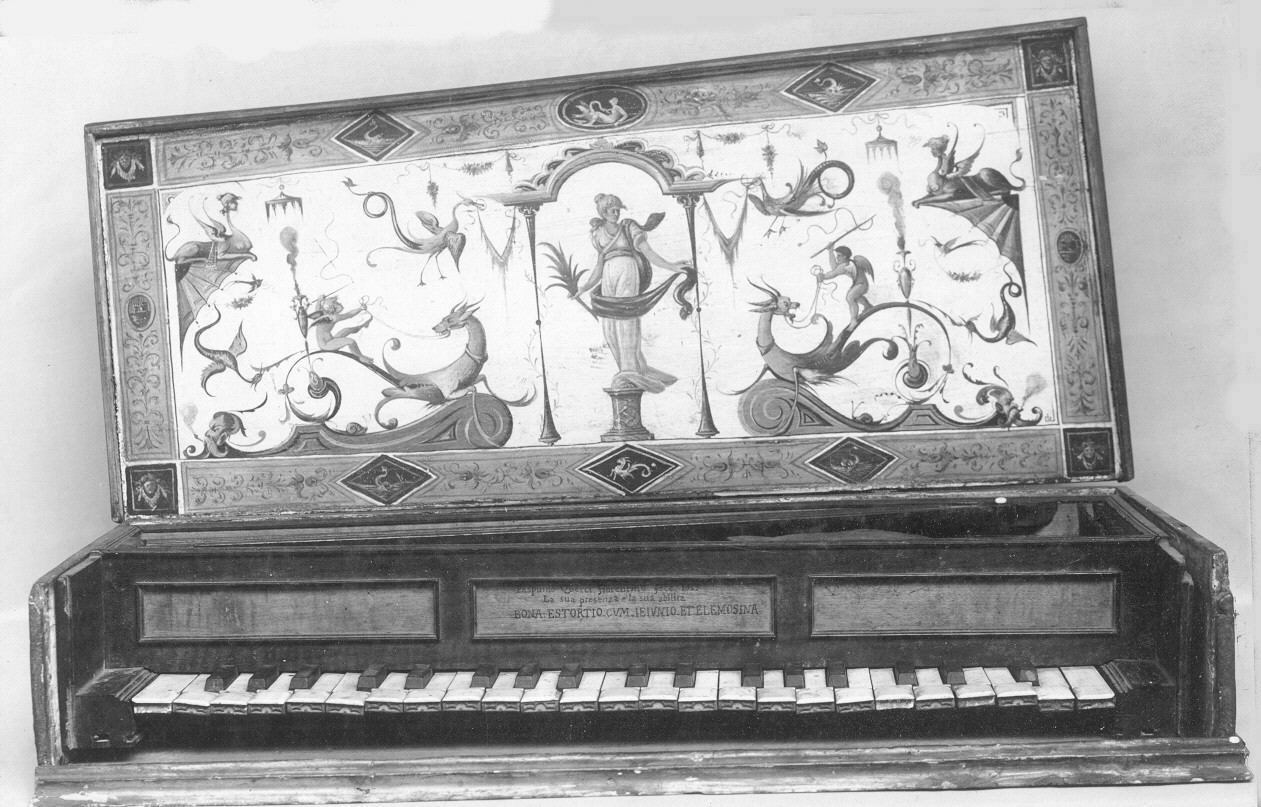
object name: rectangular octave virginal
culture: german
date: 1600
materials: wood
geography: germany